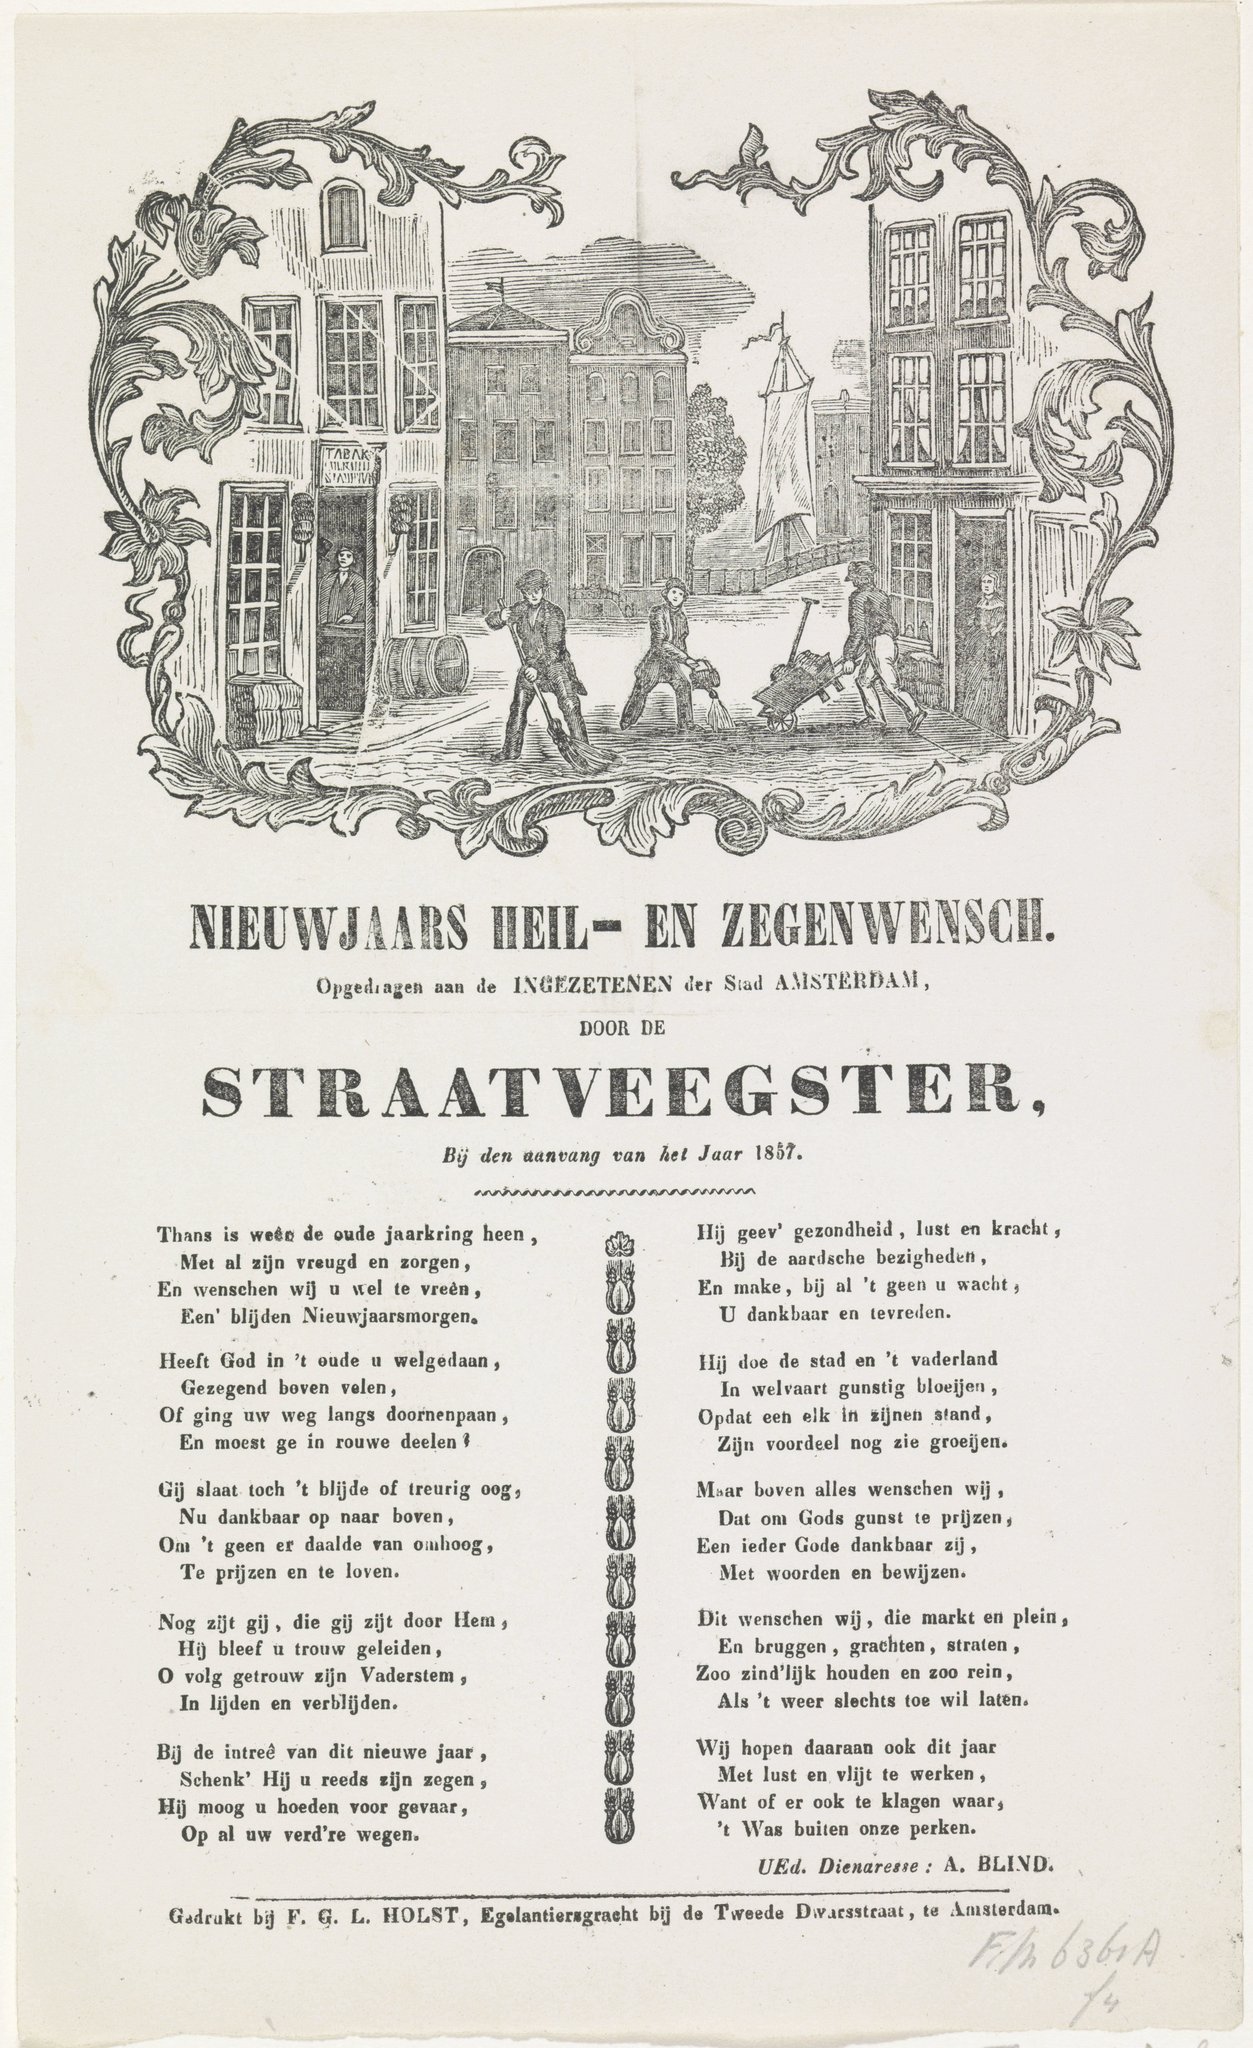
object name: print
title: Nieuwjaars Heil- en Zegenwensch (...) door de Straatveegster (...) 1857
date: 1856-1857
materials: paper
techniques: letterpress printing, engraving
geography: amsterdam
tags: street - ii - ideal city, street sweeping, street sweeper, amsterdam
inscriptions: collector's mark: Lugt 2228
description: Nieuwjaarswens van de Amsterdamse straatveegsters voor het jaar 1857. Gezicht in een straat te Amsterdam, waar twee straatvegers aan het werk zijn. Met een vers in twee kolommen. Namens de straatveegster: A. Blind.